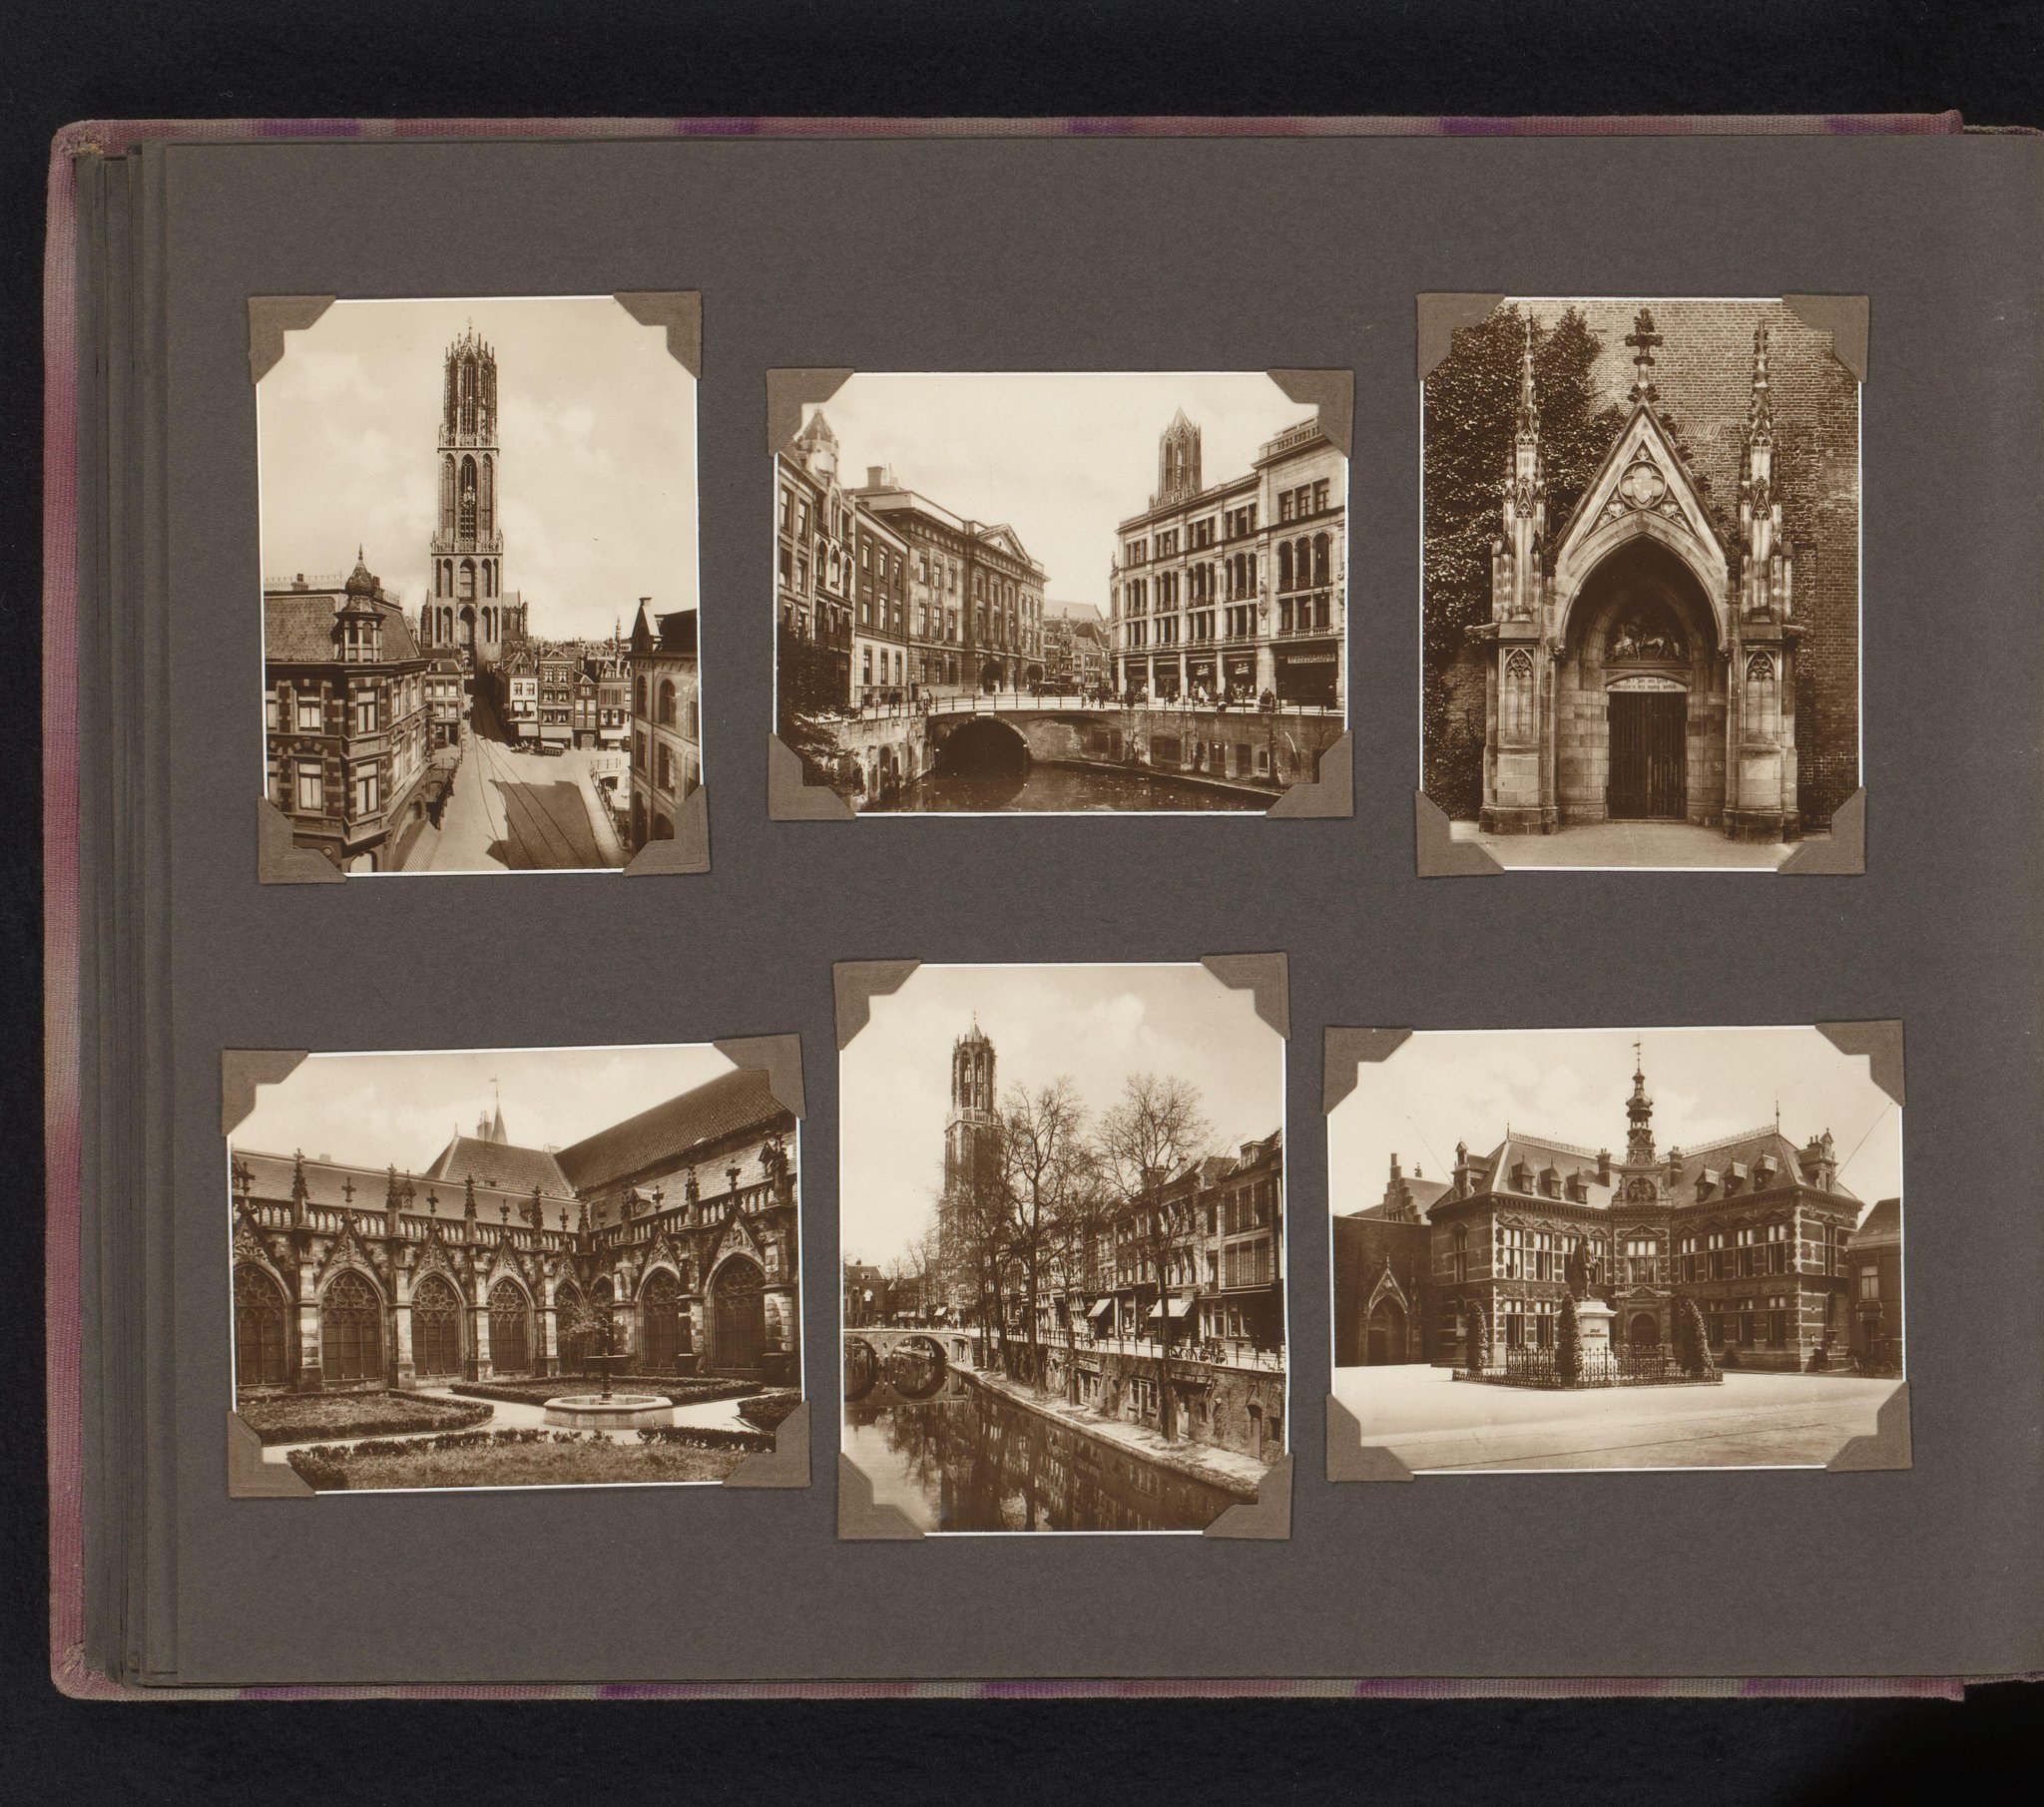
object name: photograph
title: Zes gezichten op Utrecht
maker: Anonymous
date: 1930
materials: cardboard, photographic support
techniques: gelatin silver print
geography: utrecht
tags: tower, clock tower ~ monumental adornment, canals, waters (in city), prospect of city, town panorama, silhouette of city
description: Afgebeeld zijn onder andere een gezicht op de Dom, de Oudegracht en het Domplein. Bijgevoegd is een kaart met de tekst: "12 Foto's van Utrecht voor Uw Verzamelalbum. Prijs 60 Cents. Teco/ Trinks & Co., G. m. b. H. Leipzig". Deze foto's maken deel uit van een album.